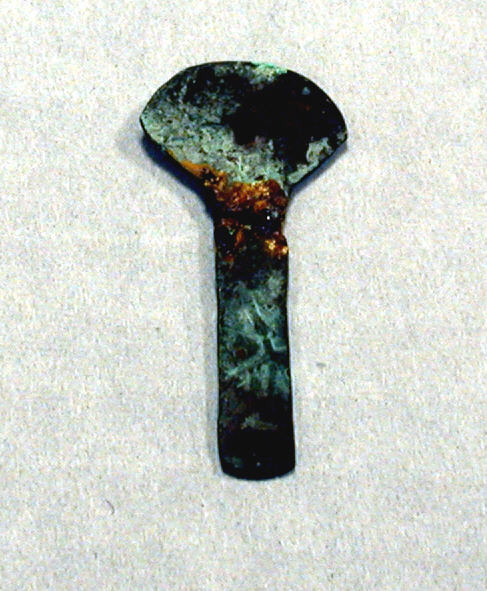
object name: knife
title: Miniature Tumi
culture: moche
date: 1-800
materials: copper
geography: peru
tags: weapons